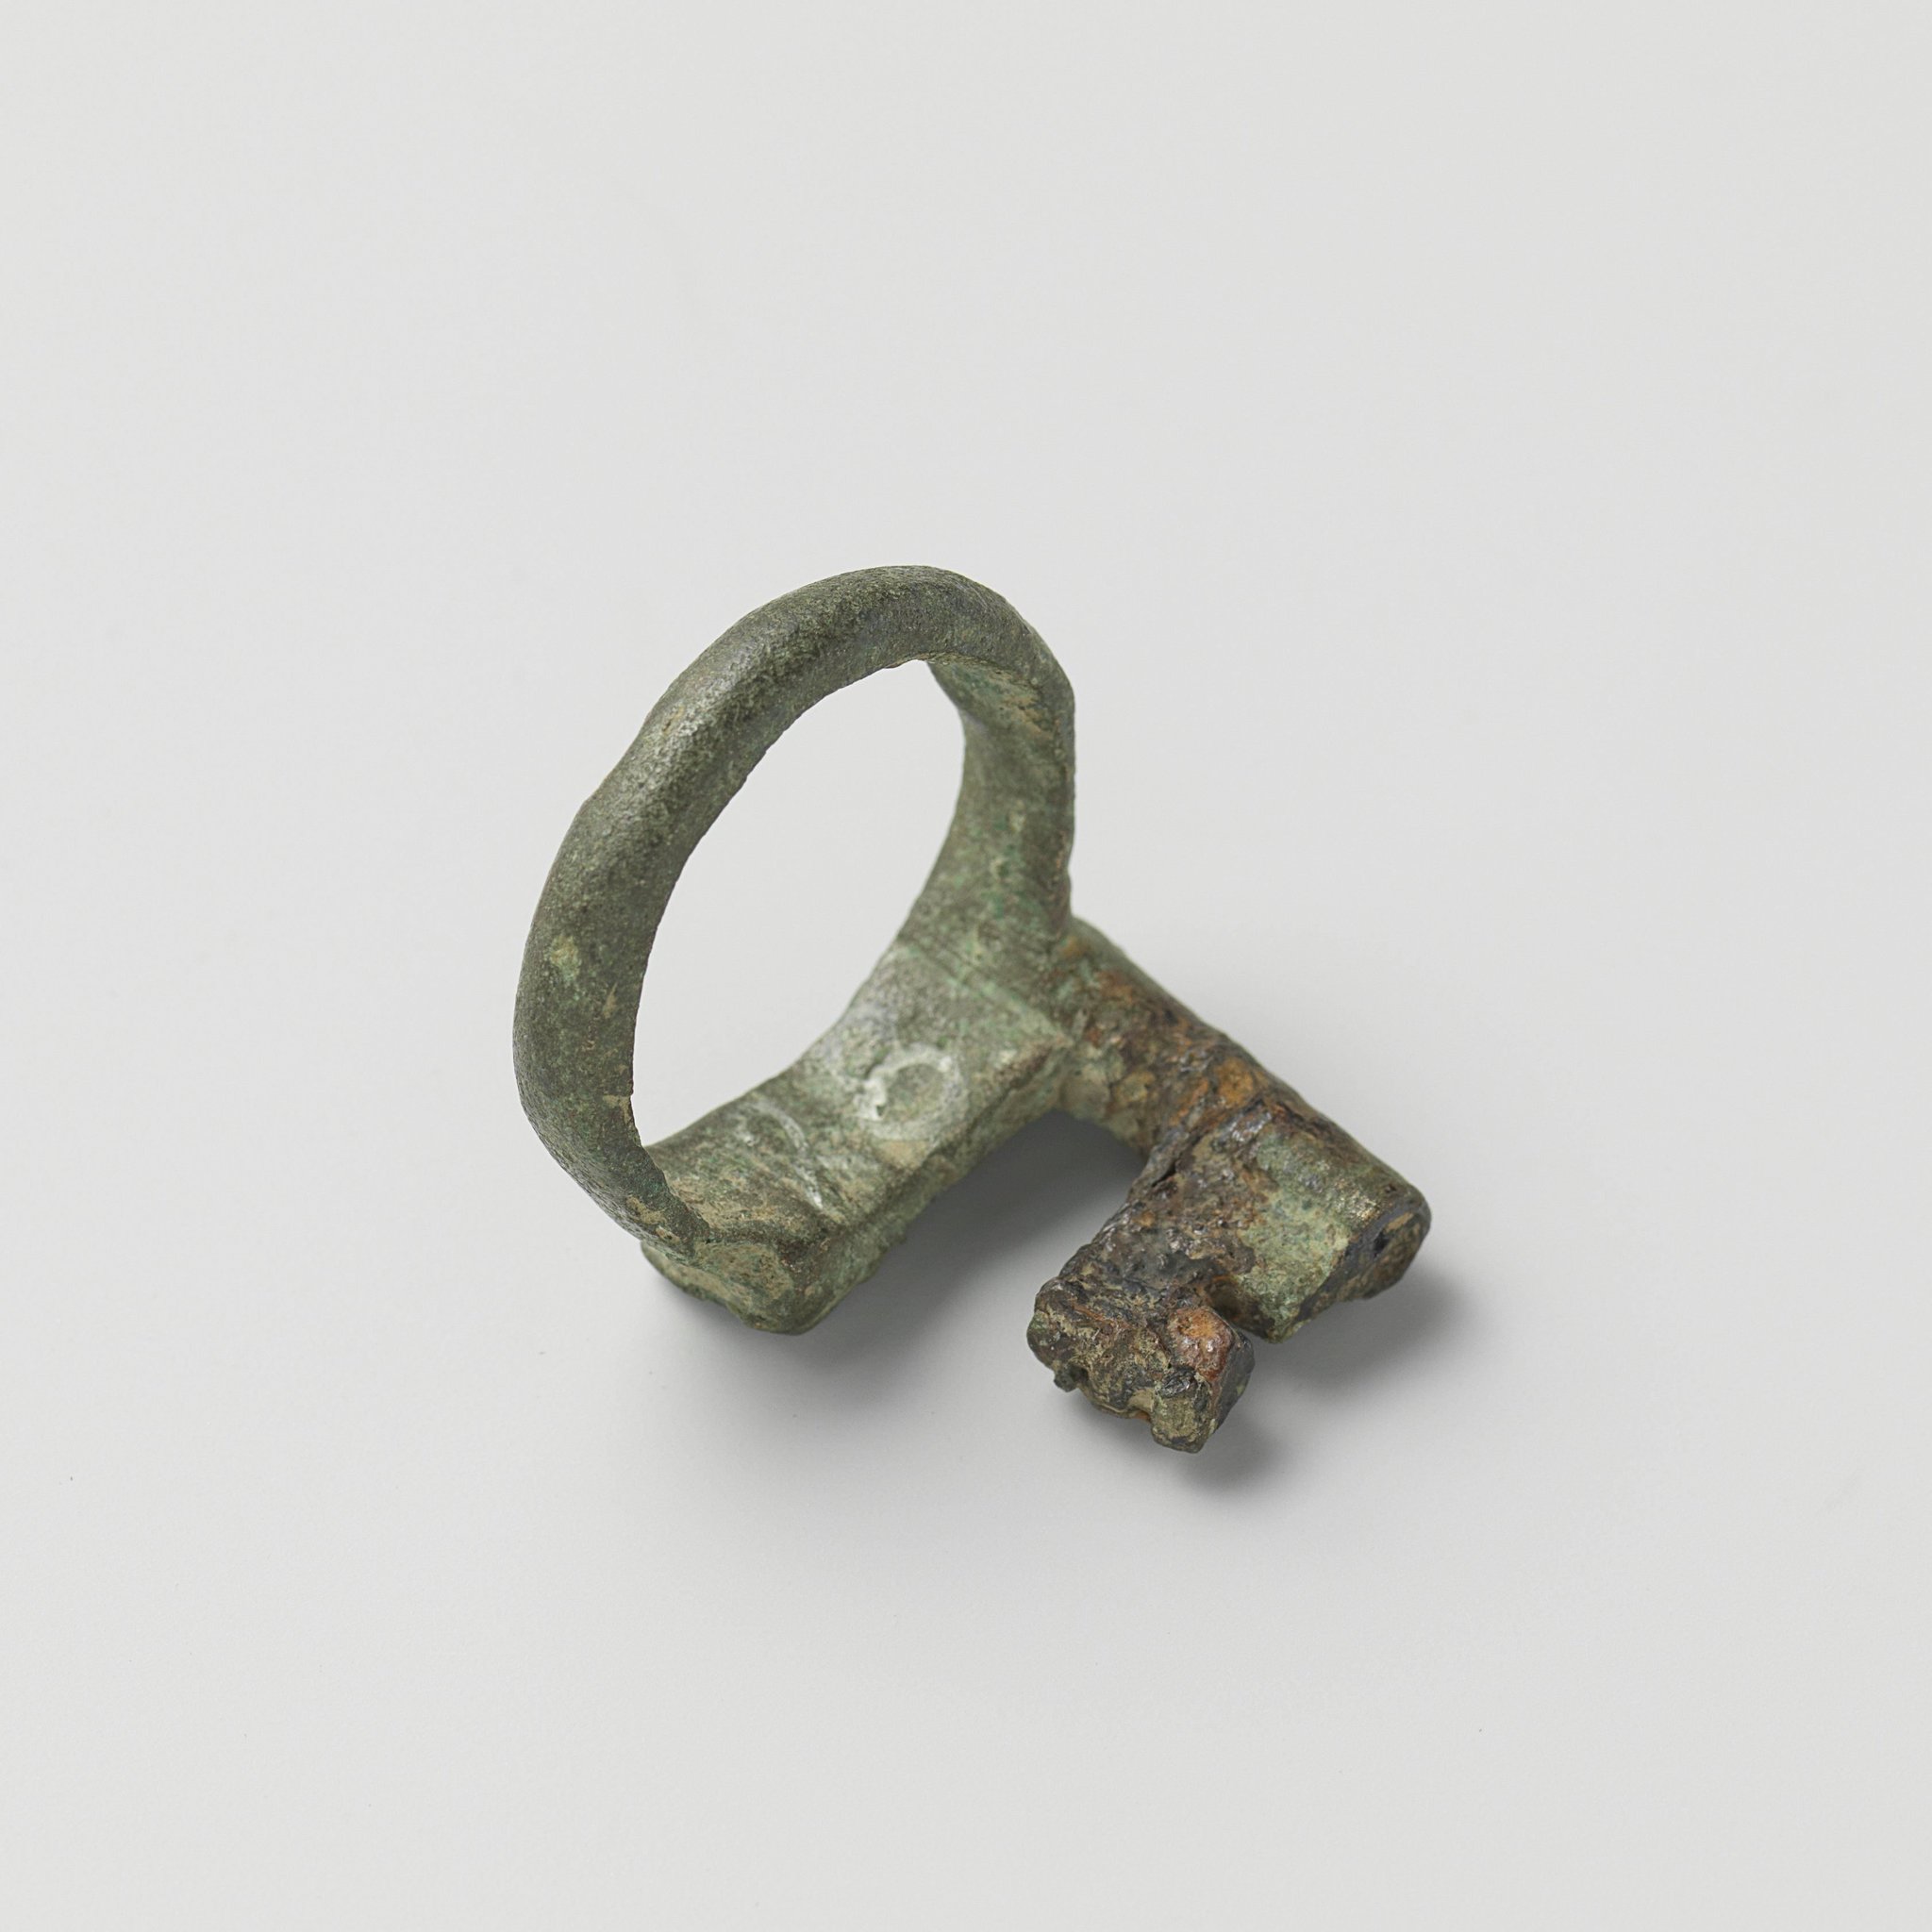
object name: draaisleutel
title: Ring key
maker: Anonymous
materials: bronze, iron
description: Ring met draaisleutel waarvan de baard en steel gedeeltelijk van ijzer zijn.